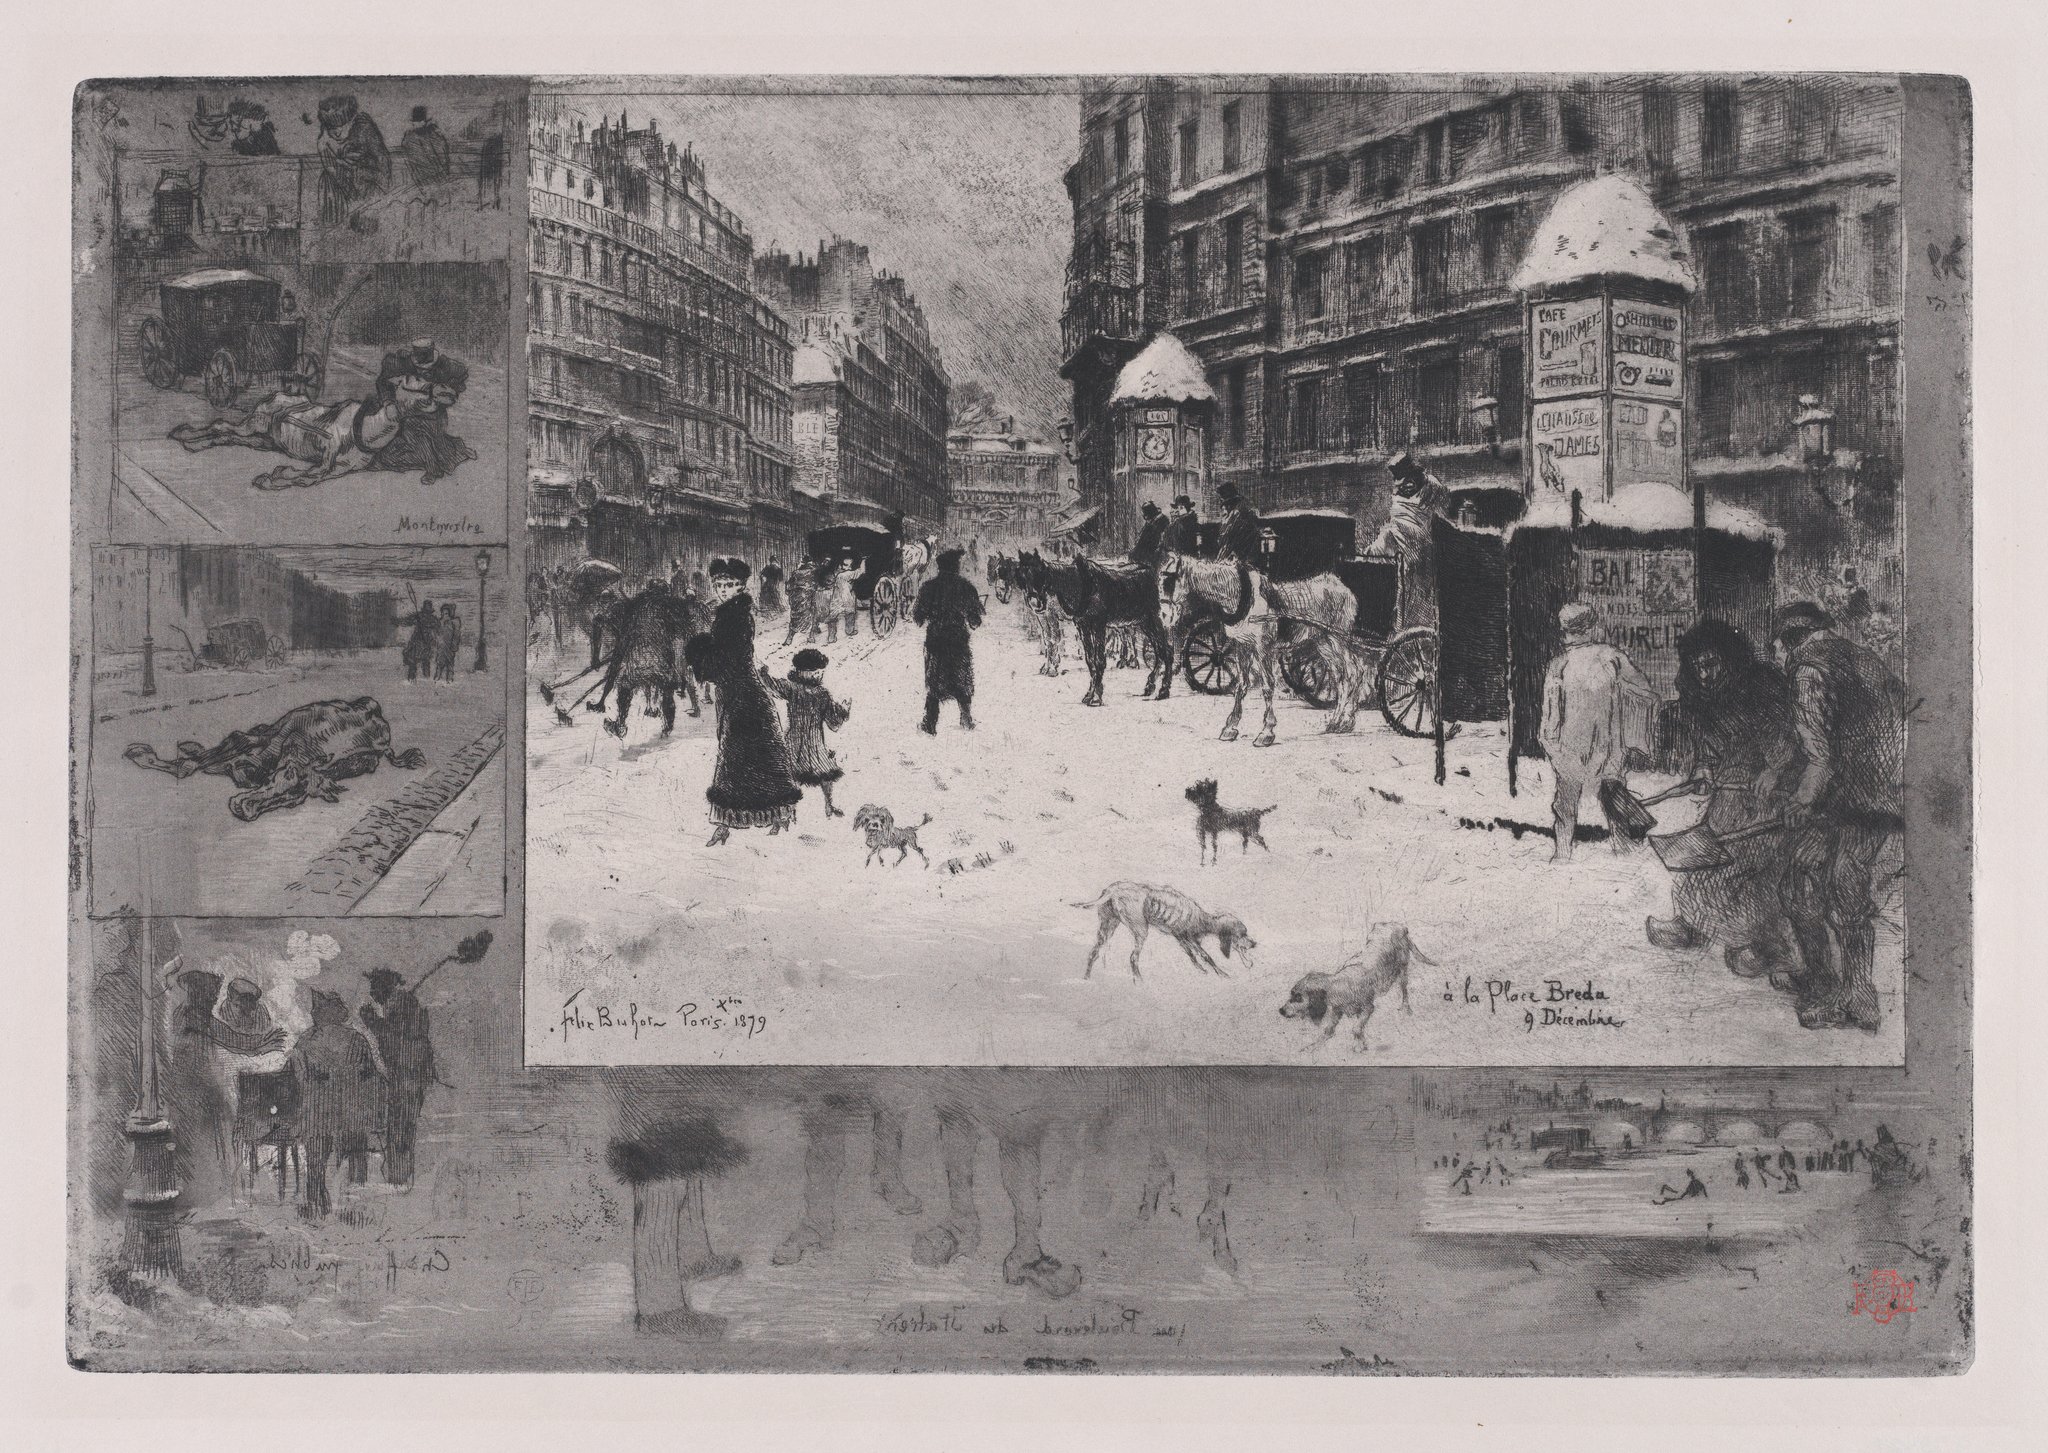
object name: print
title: Winter in Paris, or Paris in the Snow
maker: félix-hilaire buhot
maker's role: artist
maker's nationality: french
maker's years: 1847-1898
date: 1879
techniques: aquatint, drypoint, etching, roulette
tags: cities,streets,dogs,horses,winter,snow,carriages,paris